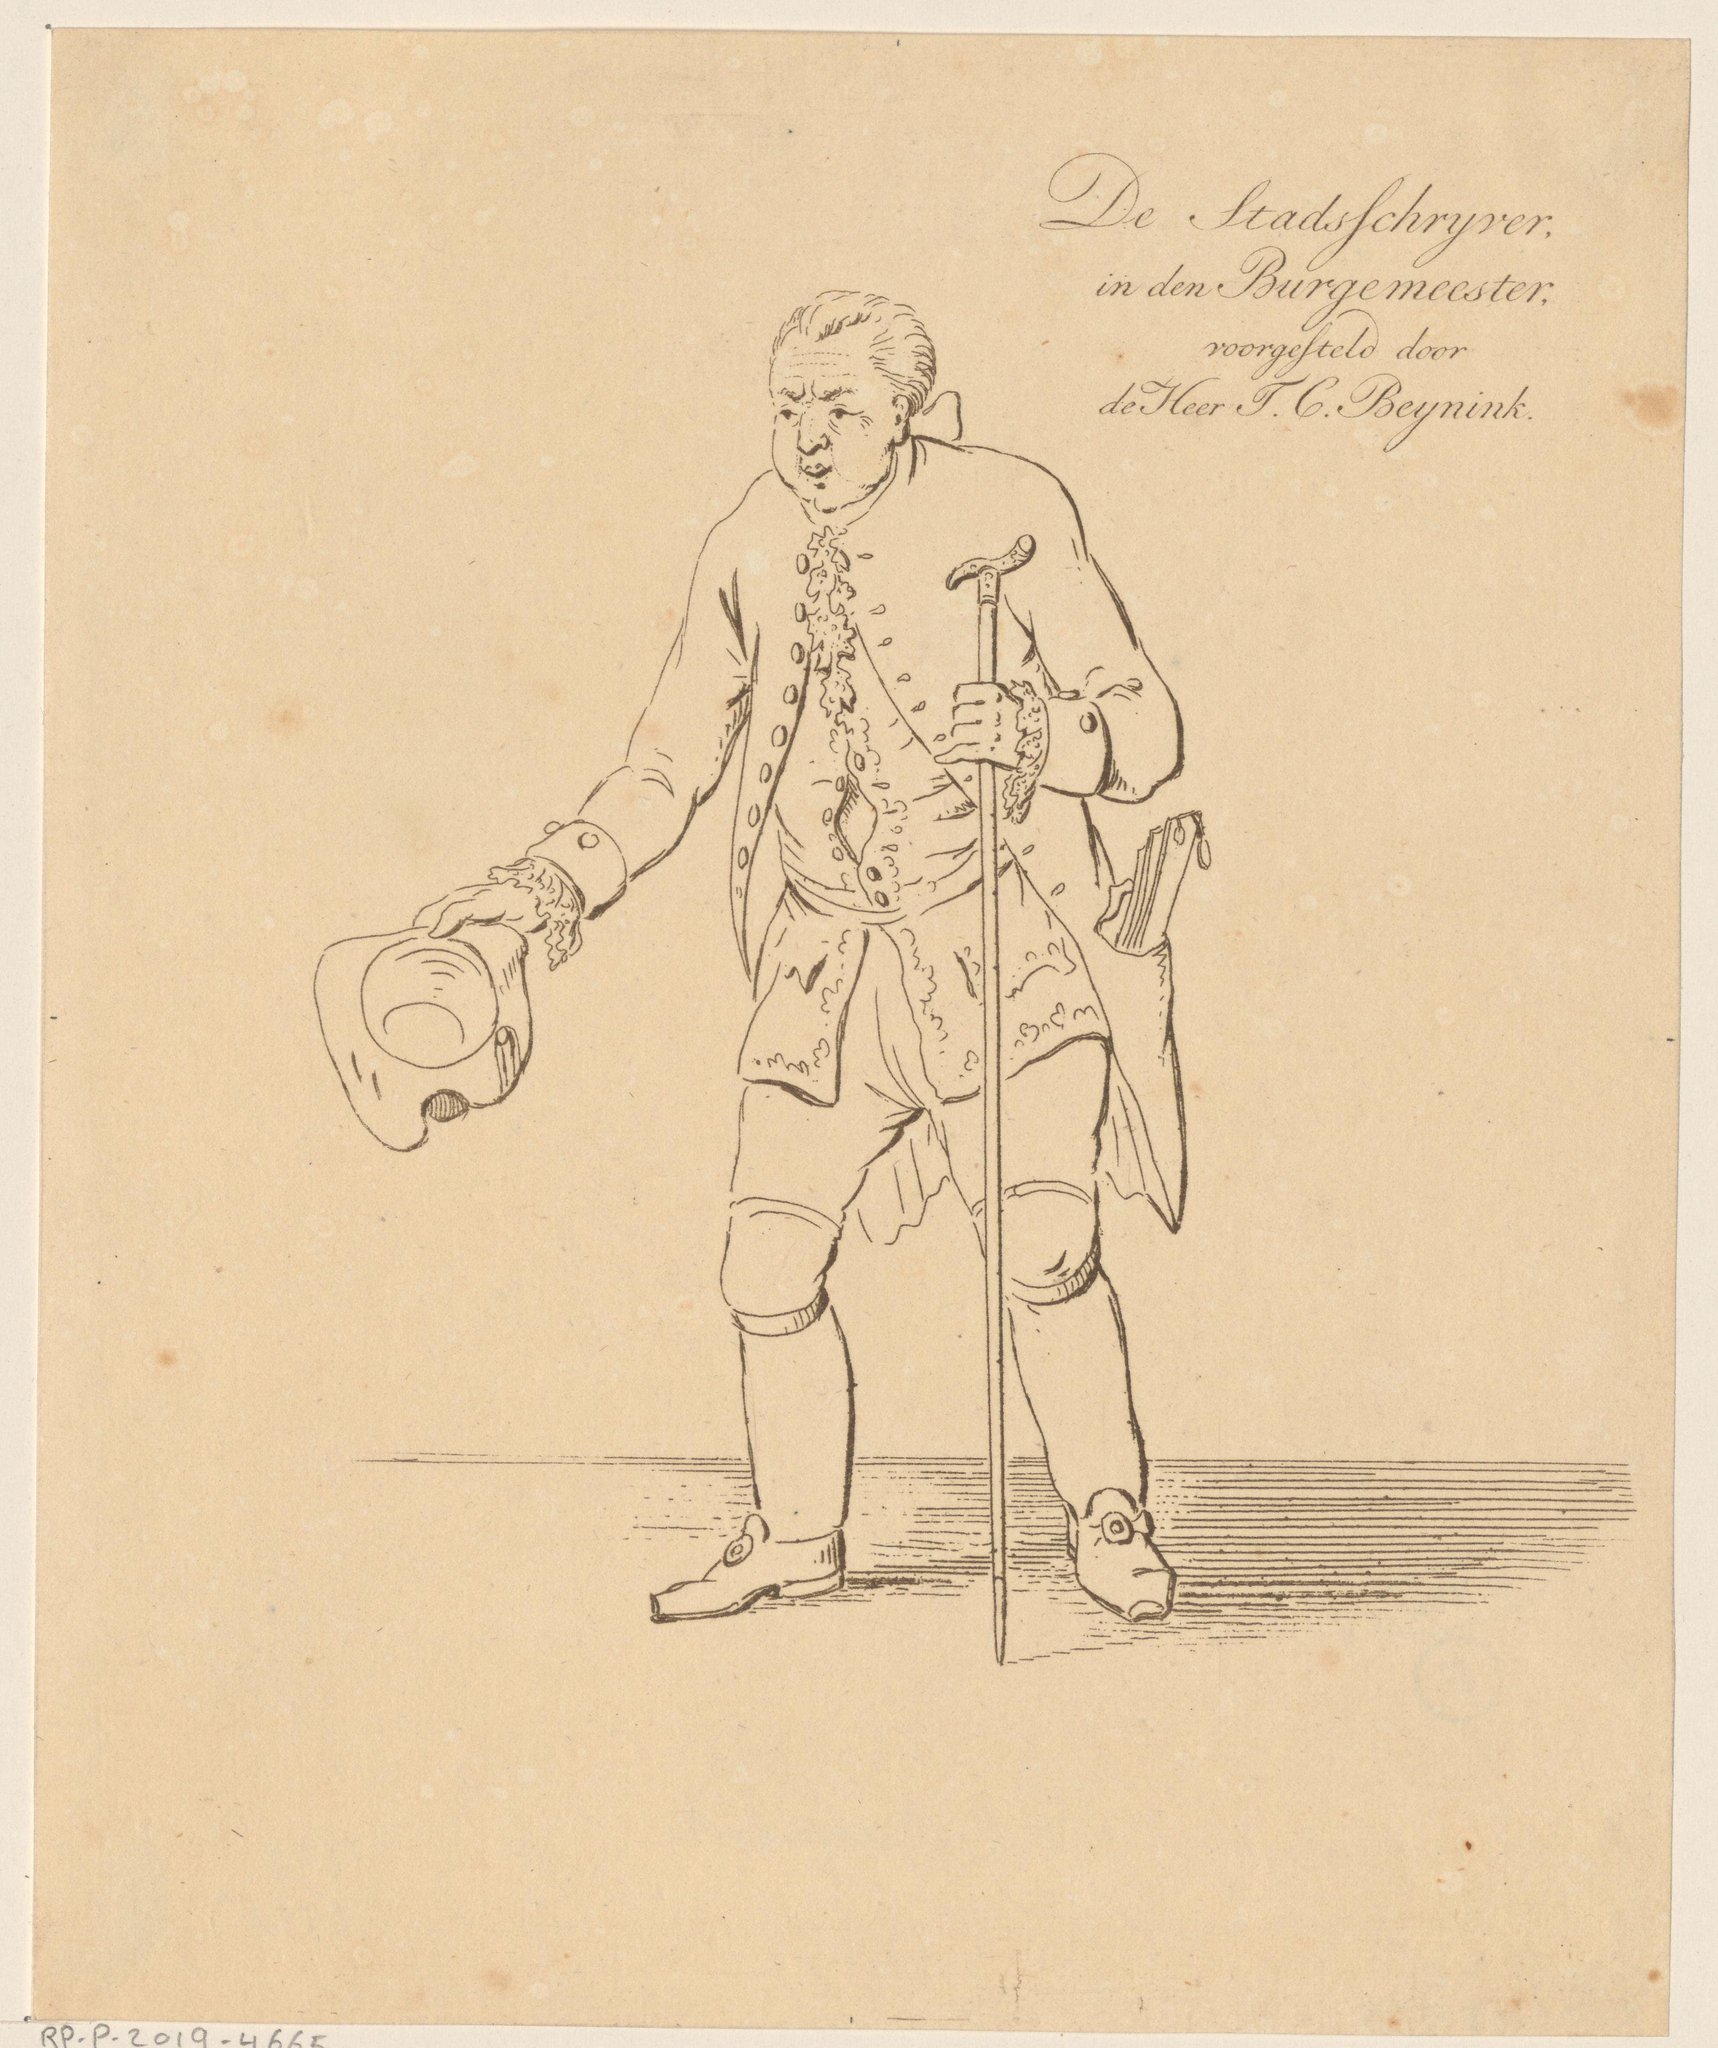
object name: print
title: Acteurs en actrices in verschillende rollen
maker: johannes jelgerhuis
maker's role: draughtsman, painter, print maker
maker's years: 1770-1836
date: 1805-1836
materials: paper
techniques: etching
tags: teunis christoffel beynink, historical persons, actor (on the stage)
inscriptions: collector's mark: Lugt 964